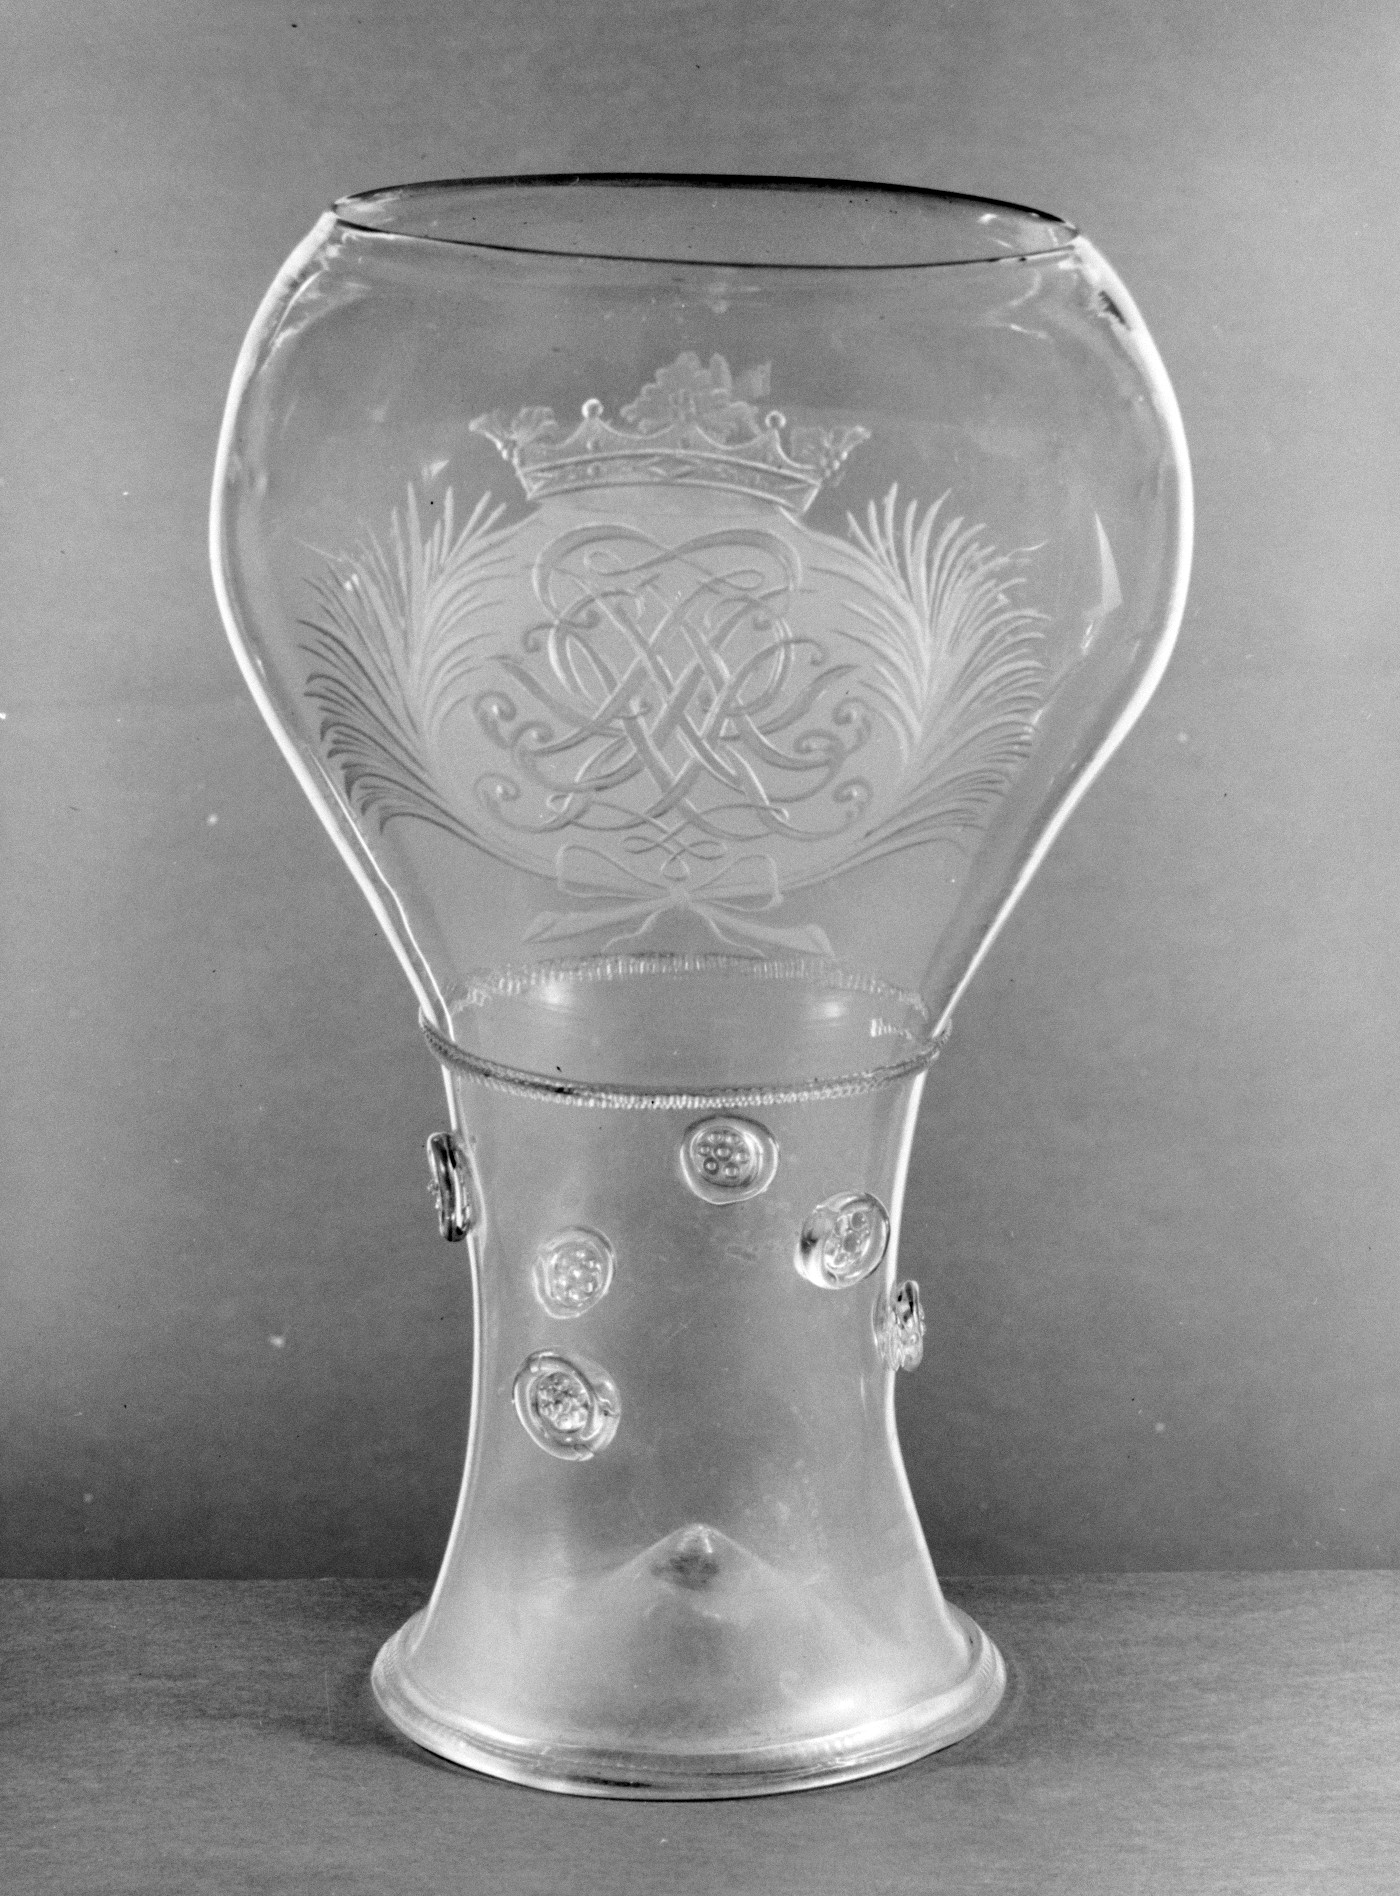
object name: roemer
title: Goblet (Roemer)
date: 1801-1900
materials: glass